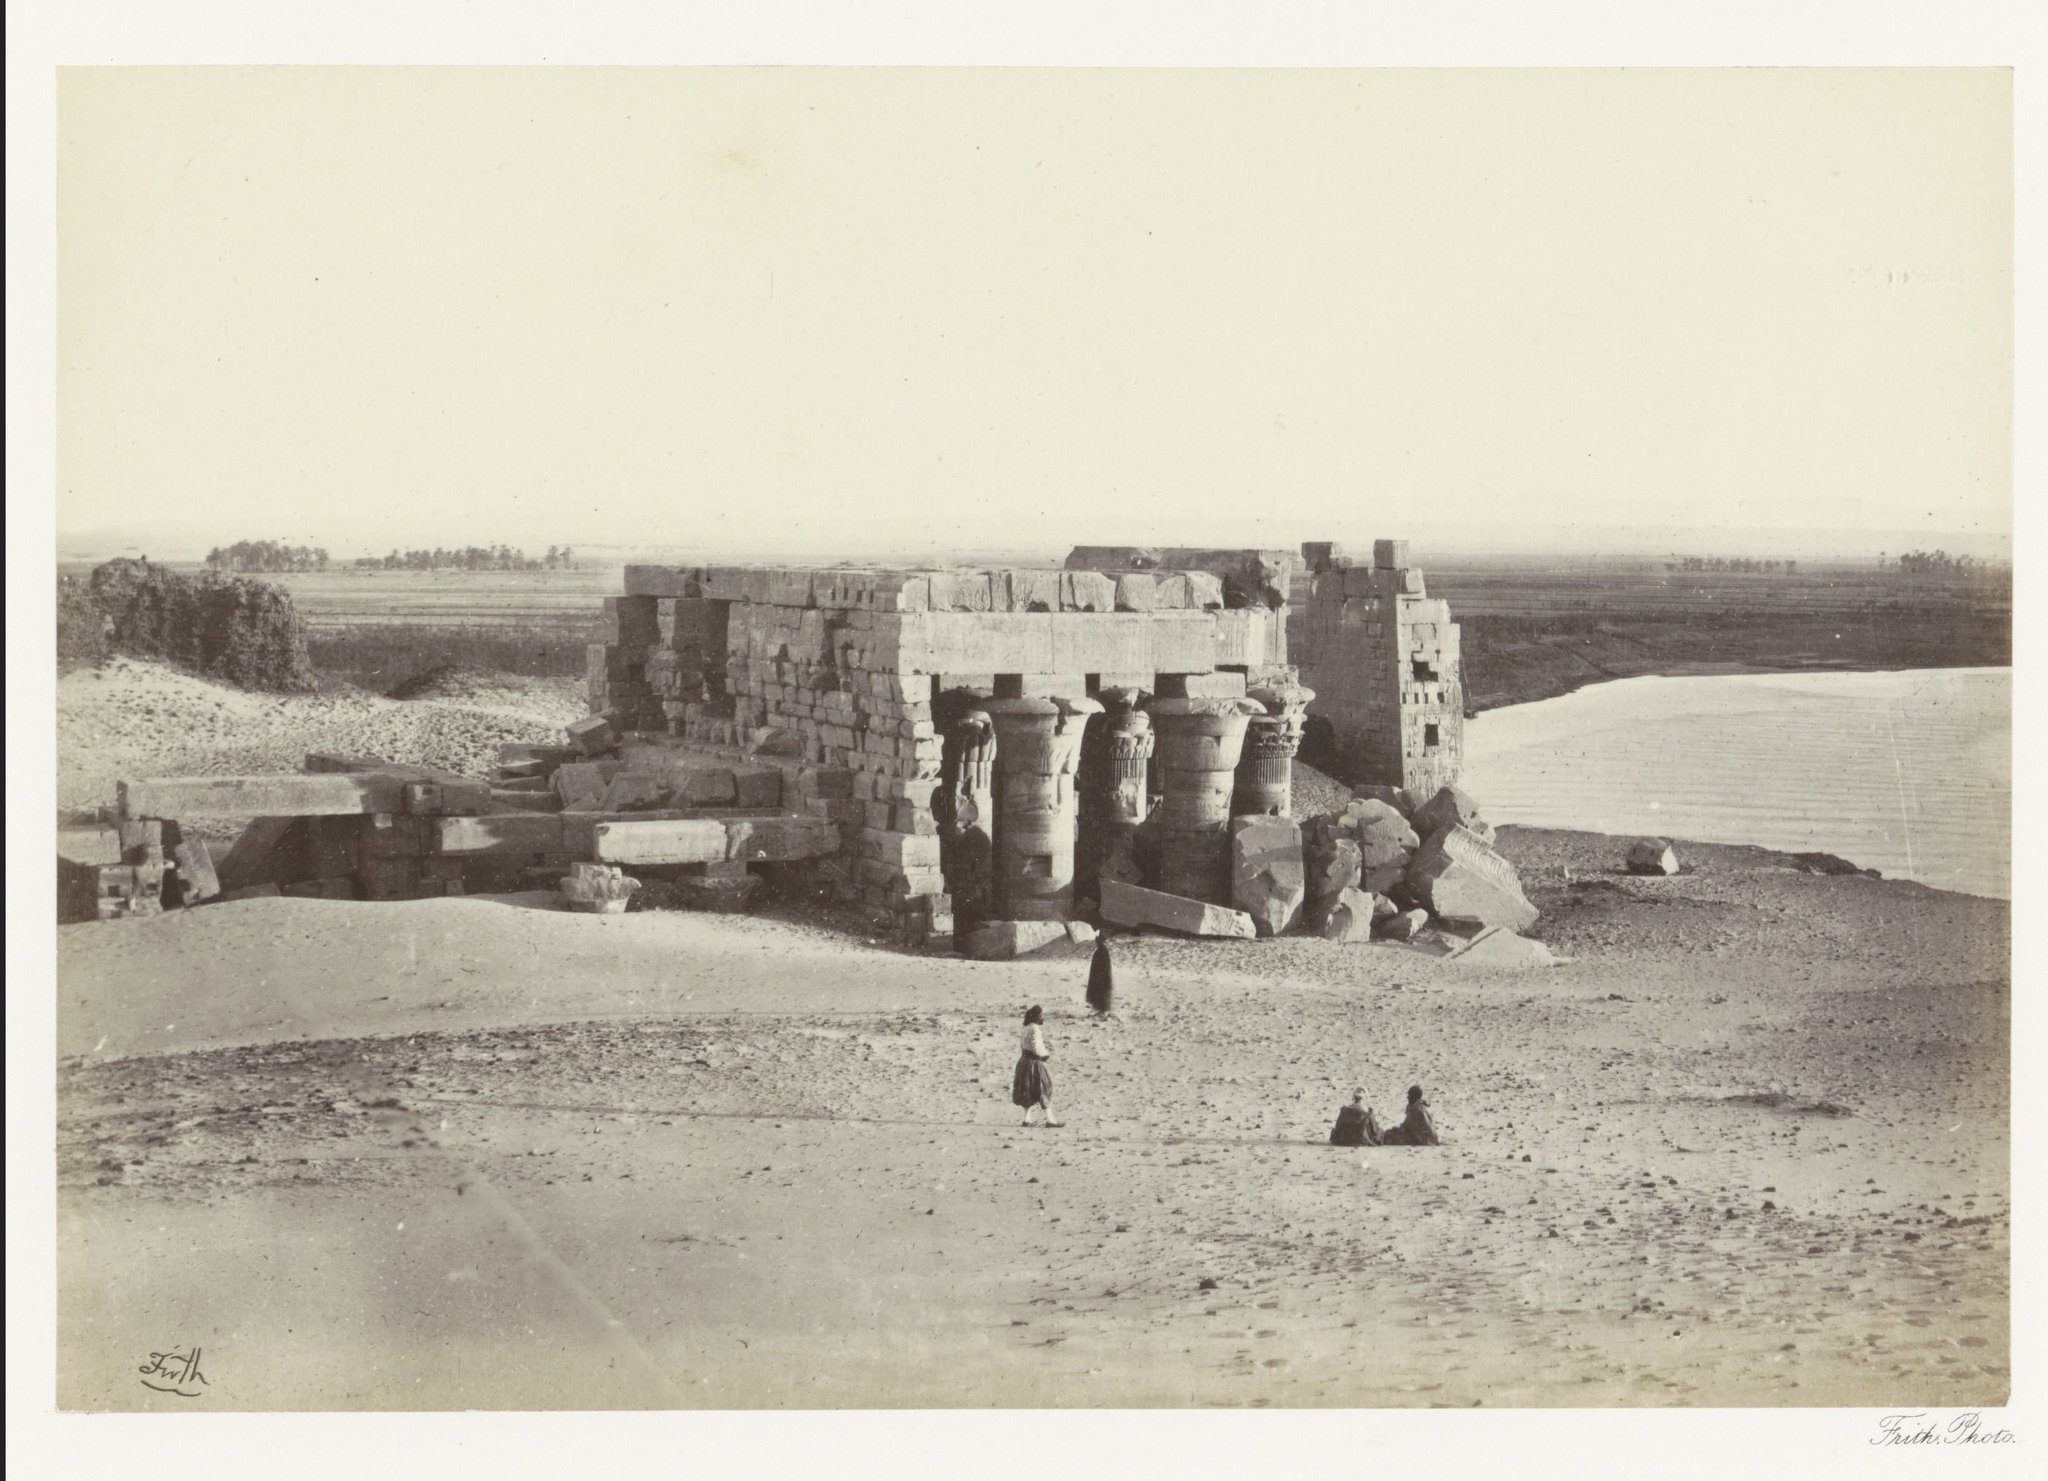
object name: photograph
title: Koum Ombo. From the North East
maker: francis frith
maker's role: publisher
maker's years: 1822-1898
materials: paper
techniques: albumen print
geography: kom ombo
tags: temple, shrine ~ egyptian religion